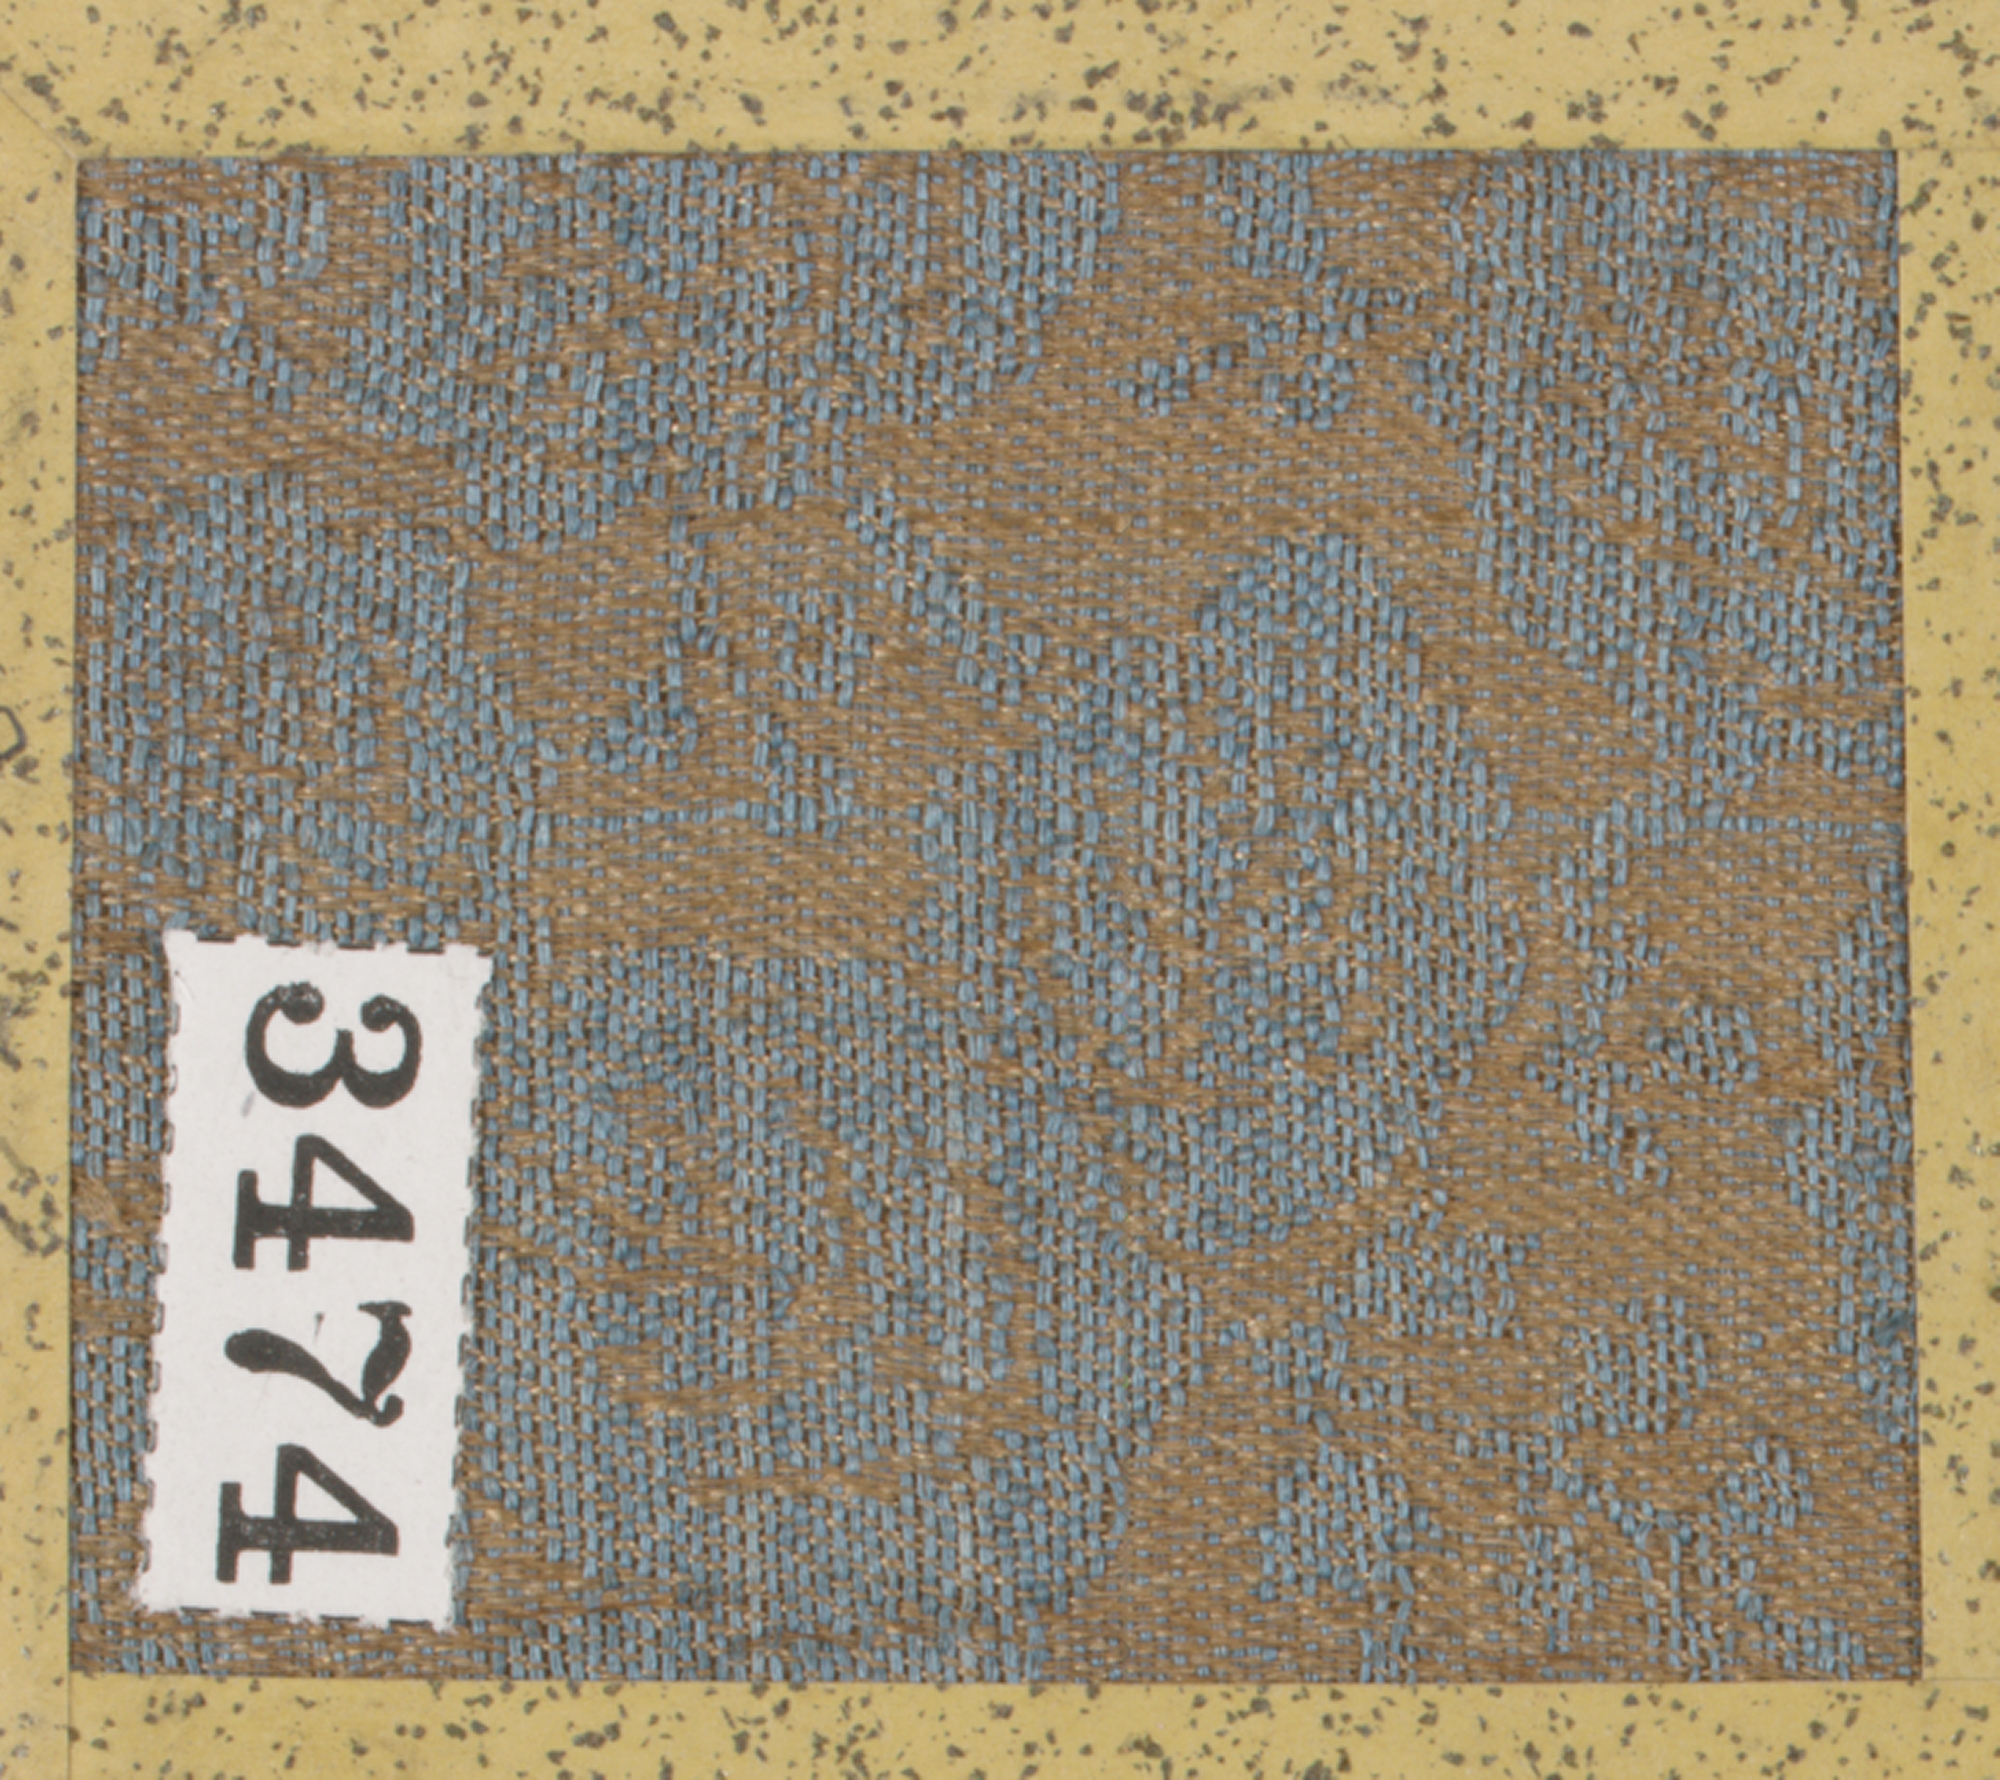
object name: sample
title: Textile Sample from Sample Book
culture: japanese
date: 1801-1900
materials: silk